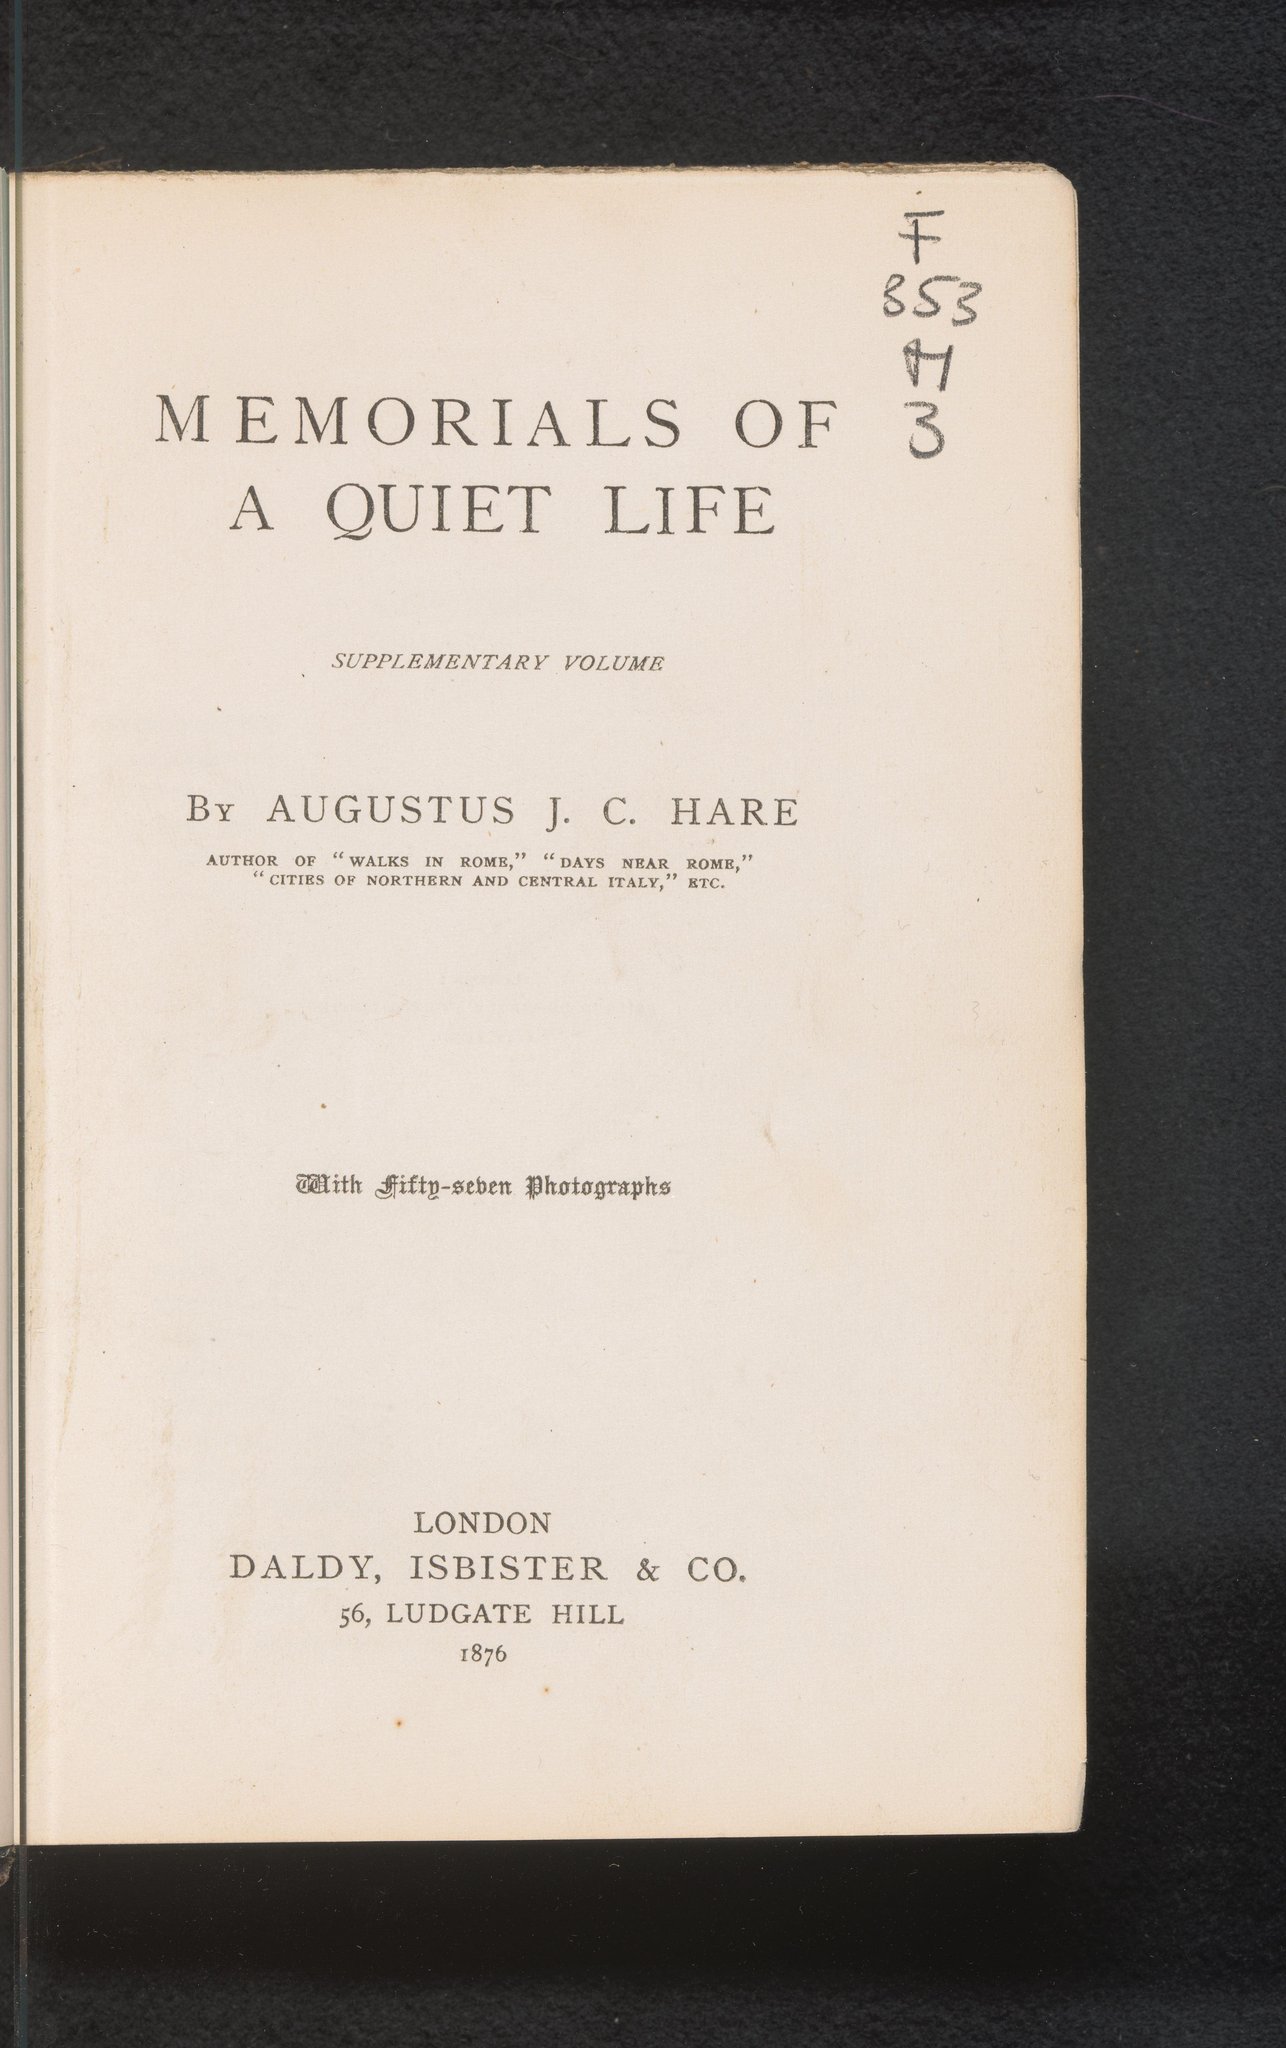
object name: book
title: Memorials of a quiet life vol. III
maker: augustus hare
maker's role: schrijver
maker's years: 1834-1903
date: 1876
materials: cardboard, linen, paper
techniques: printing, woodburytype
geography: london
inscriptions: name: ‘A.F. Bishop 1876’